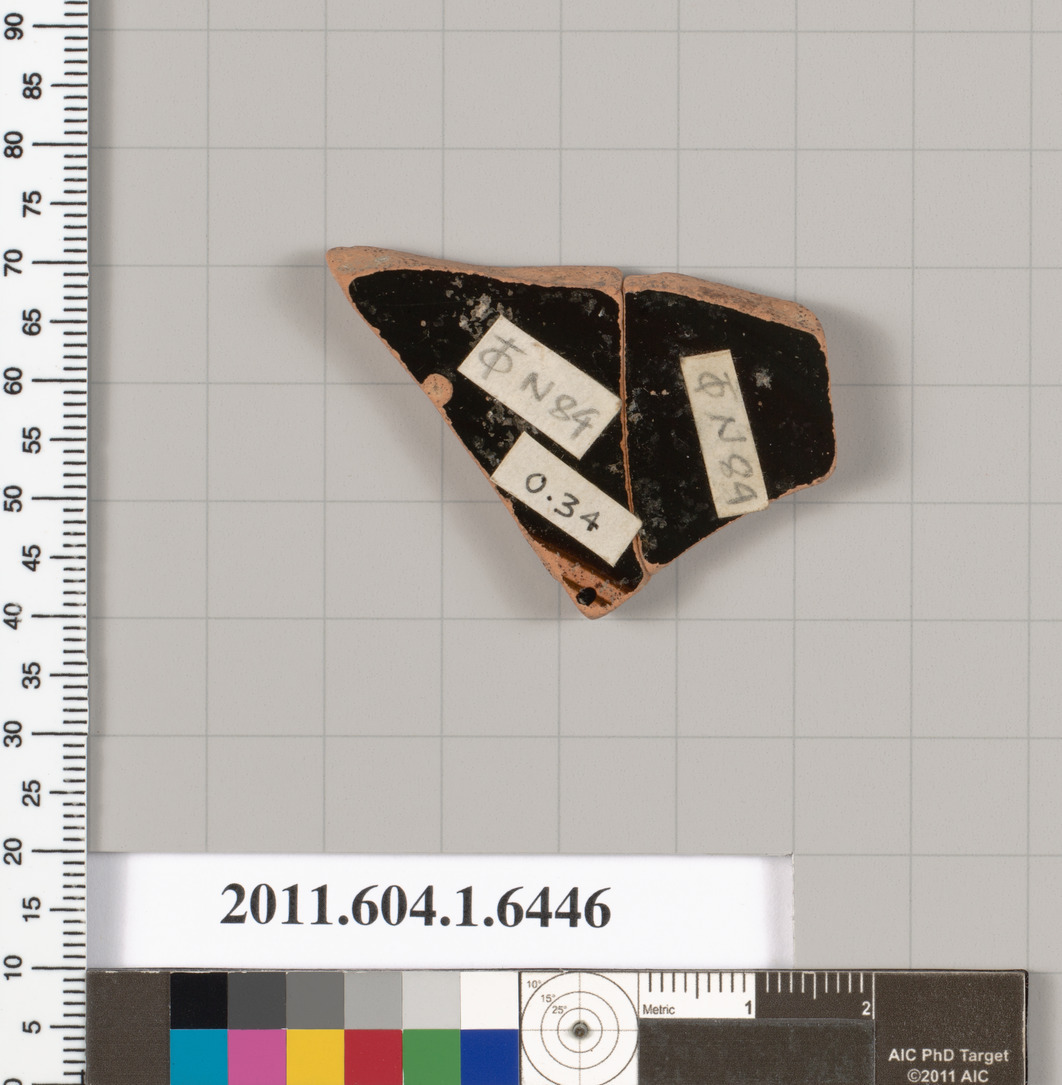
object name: kylix fragment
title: Terracotta fragment of a kylix (drinking cup)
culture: greek, attic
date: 490-480 BCE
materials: terracotta